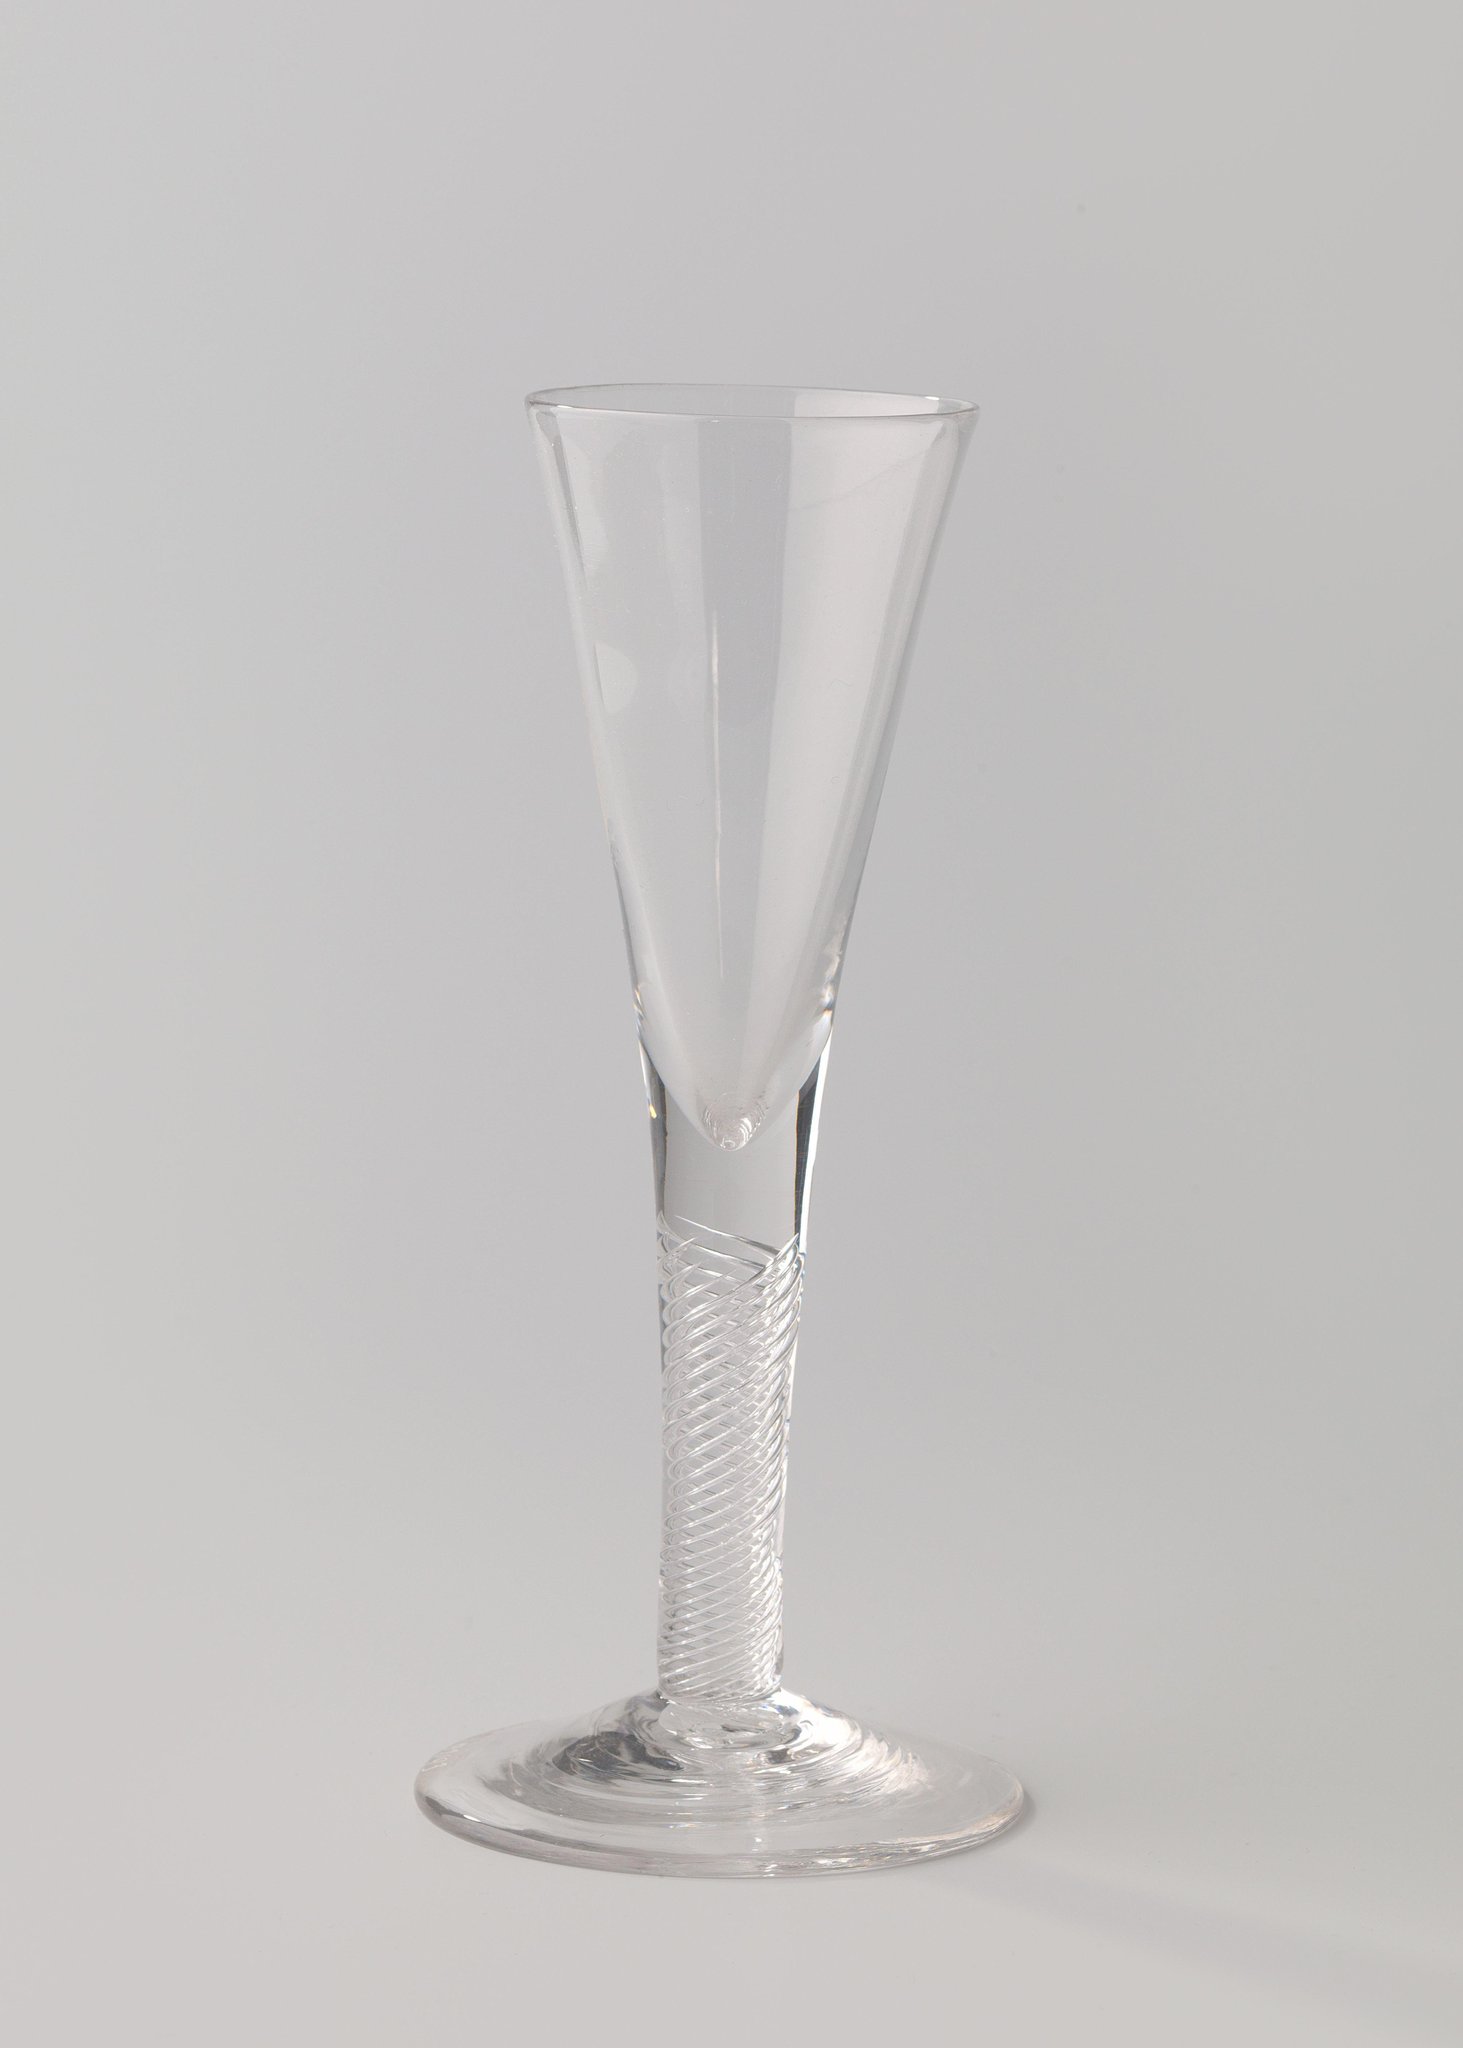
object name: goblet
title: Slingerglas met trechtervormige kelk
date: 1750-1775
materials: glass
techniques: glassblowing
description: Conische voet. Rechte, licht uitlopende stam met een meervoudige luchtslinger, overgaand in een trechtervormige kelk.